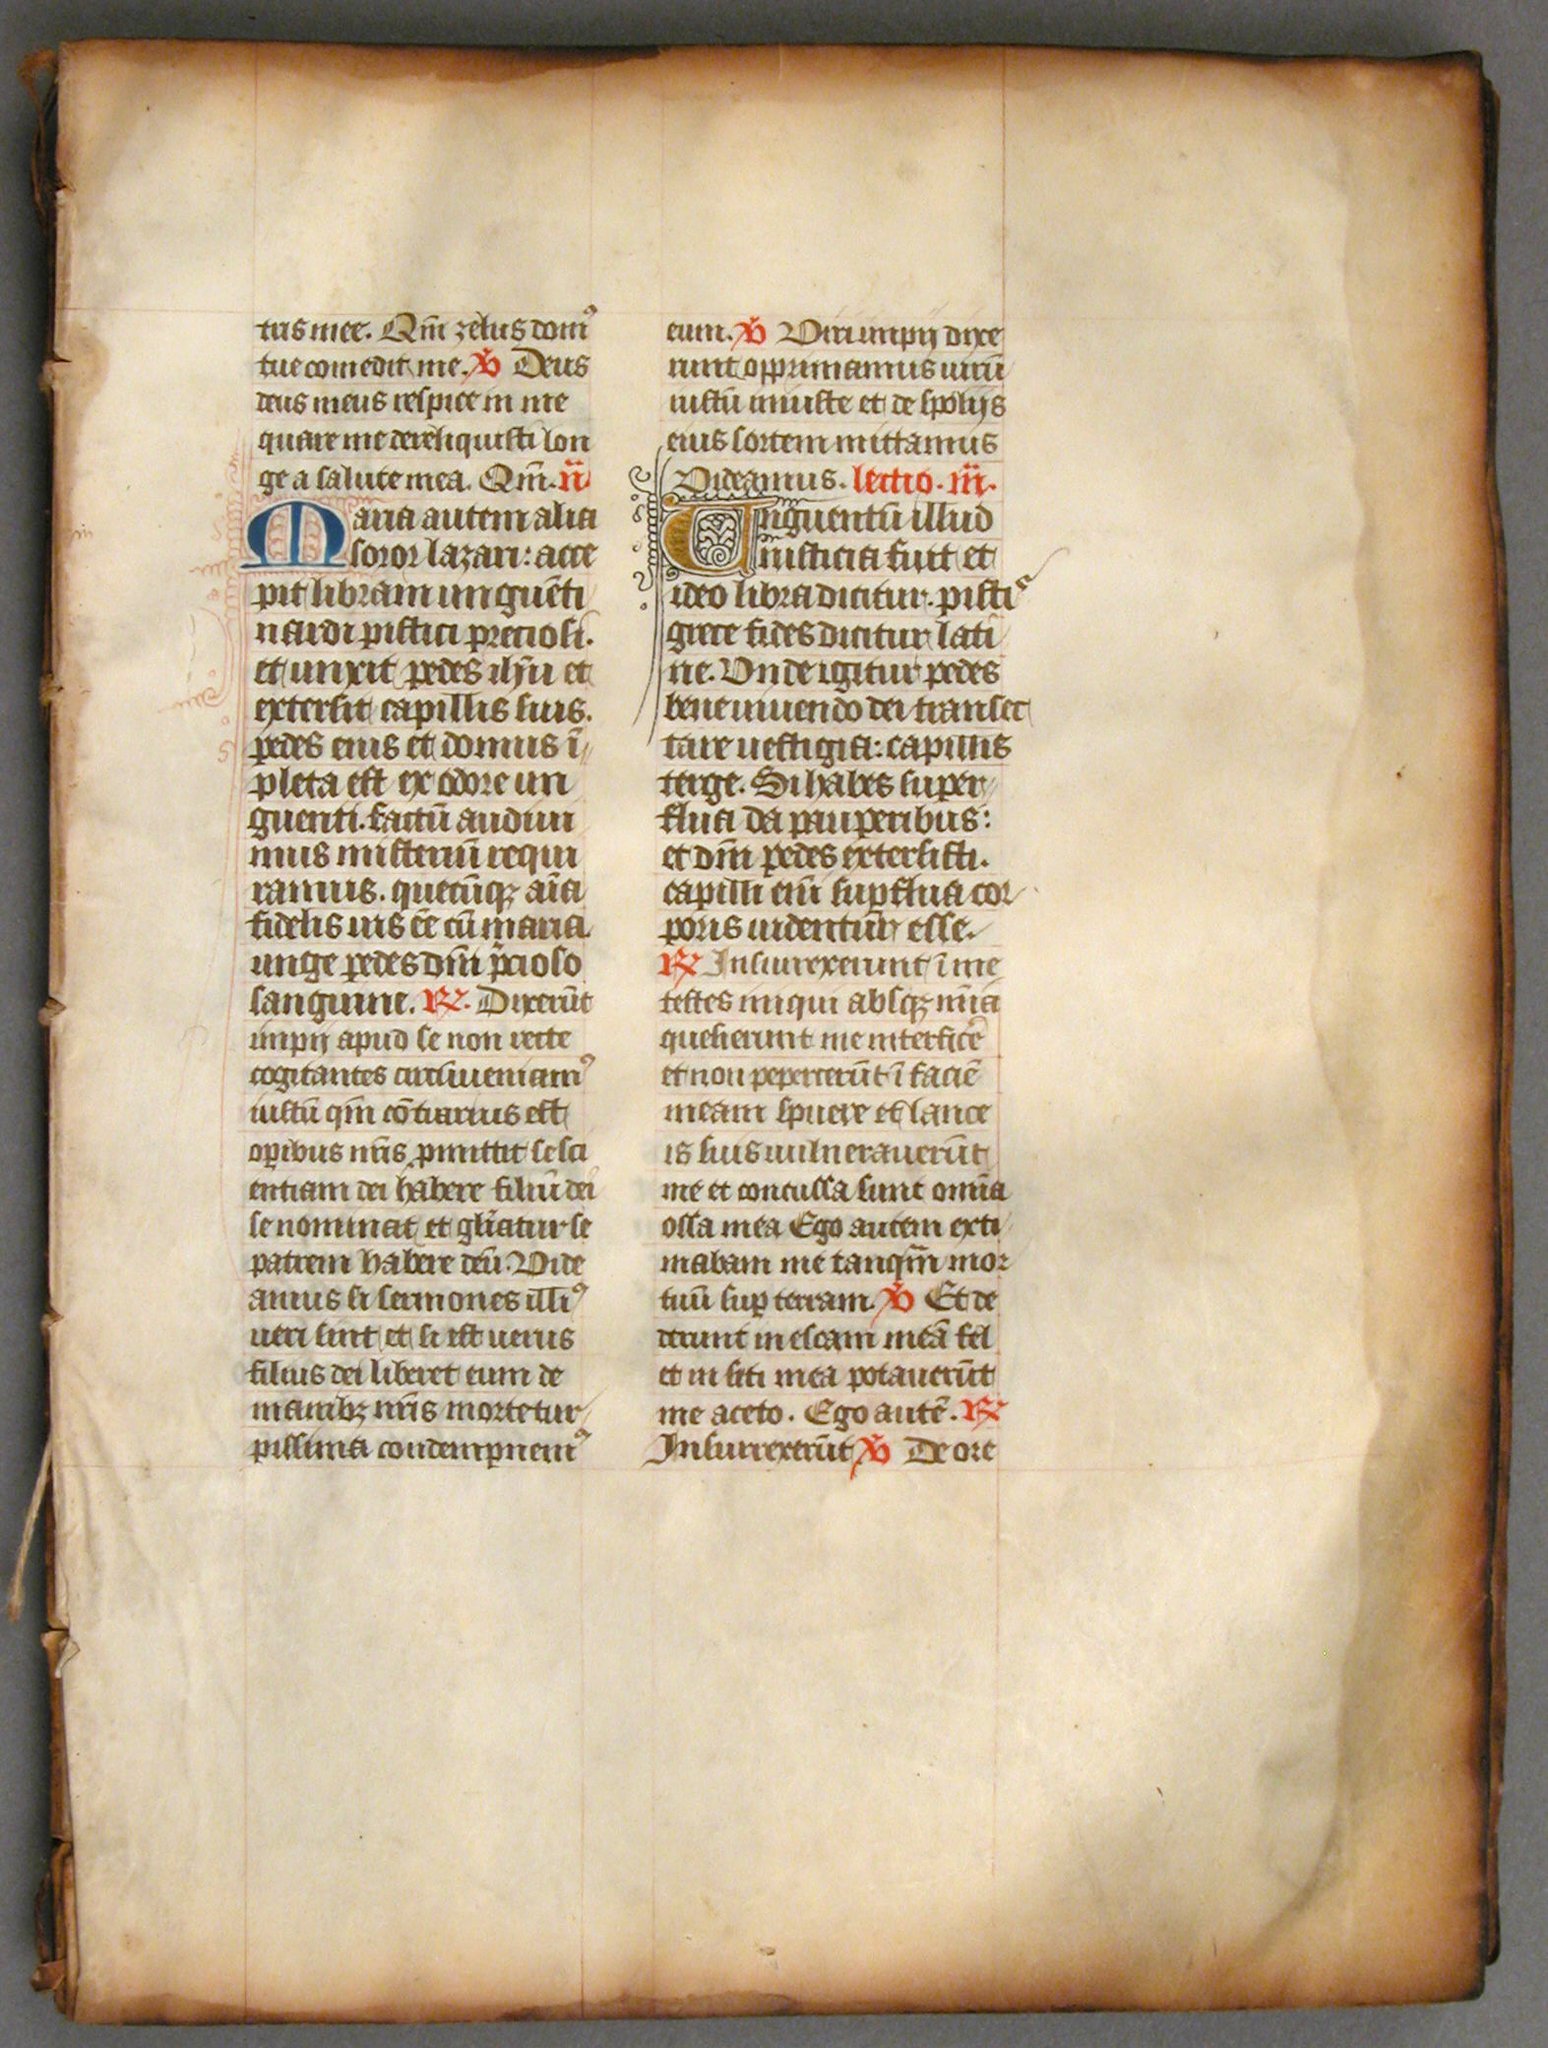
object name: missal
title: Leaves from a Missal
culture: franco-netherlandish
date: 1401-1500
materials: gold, ink, parchment